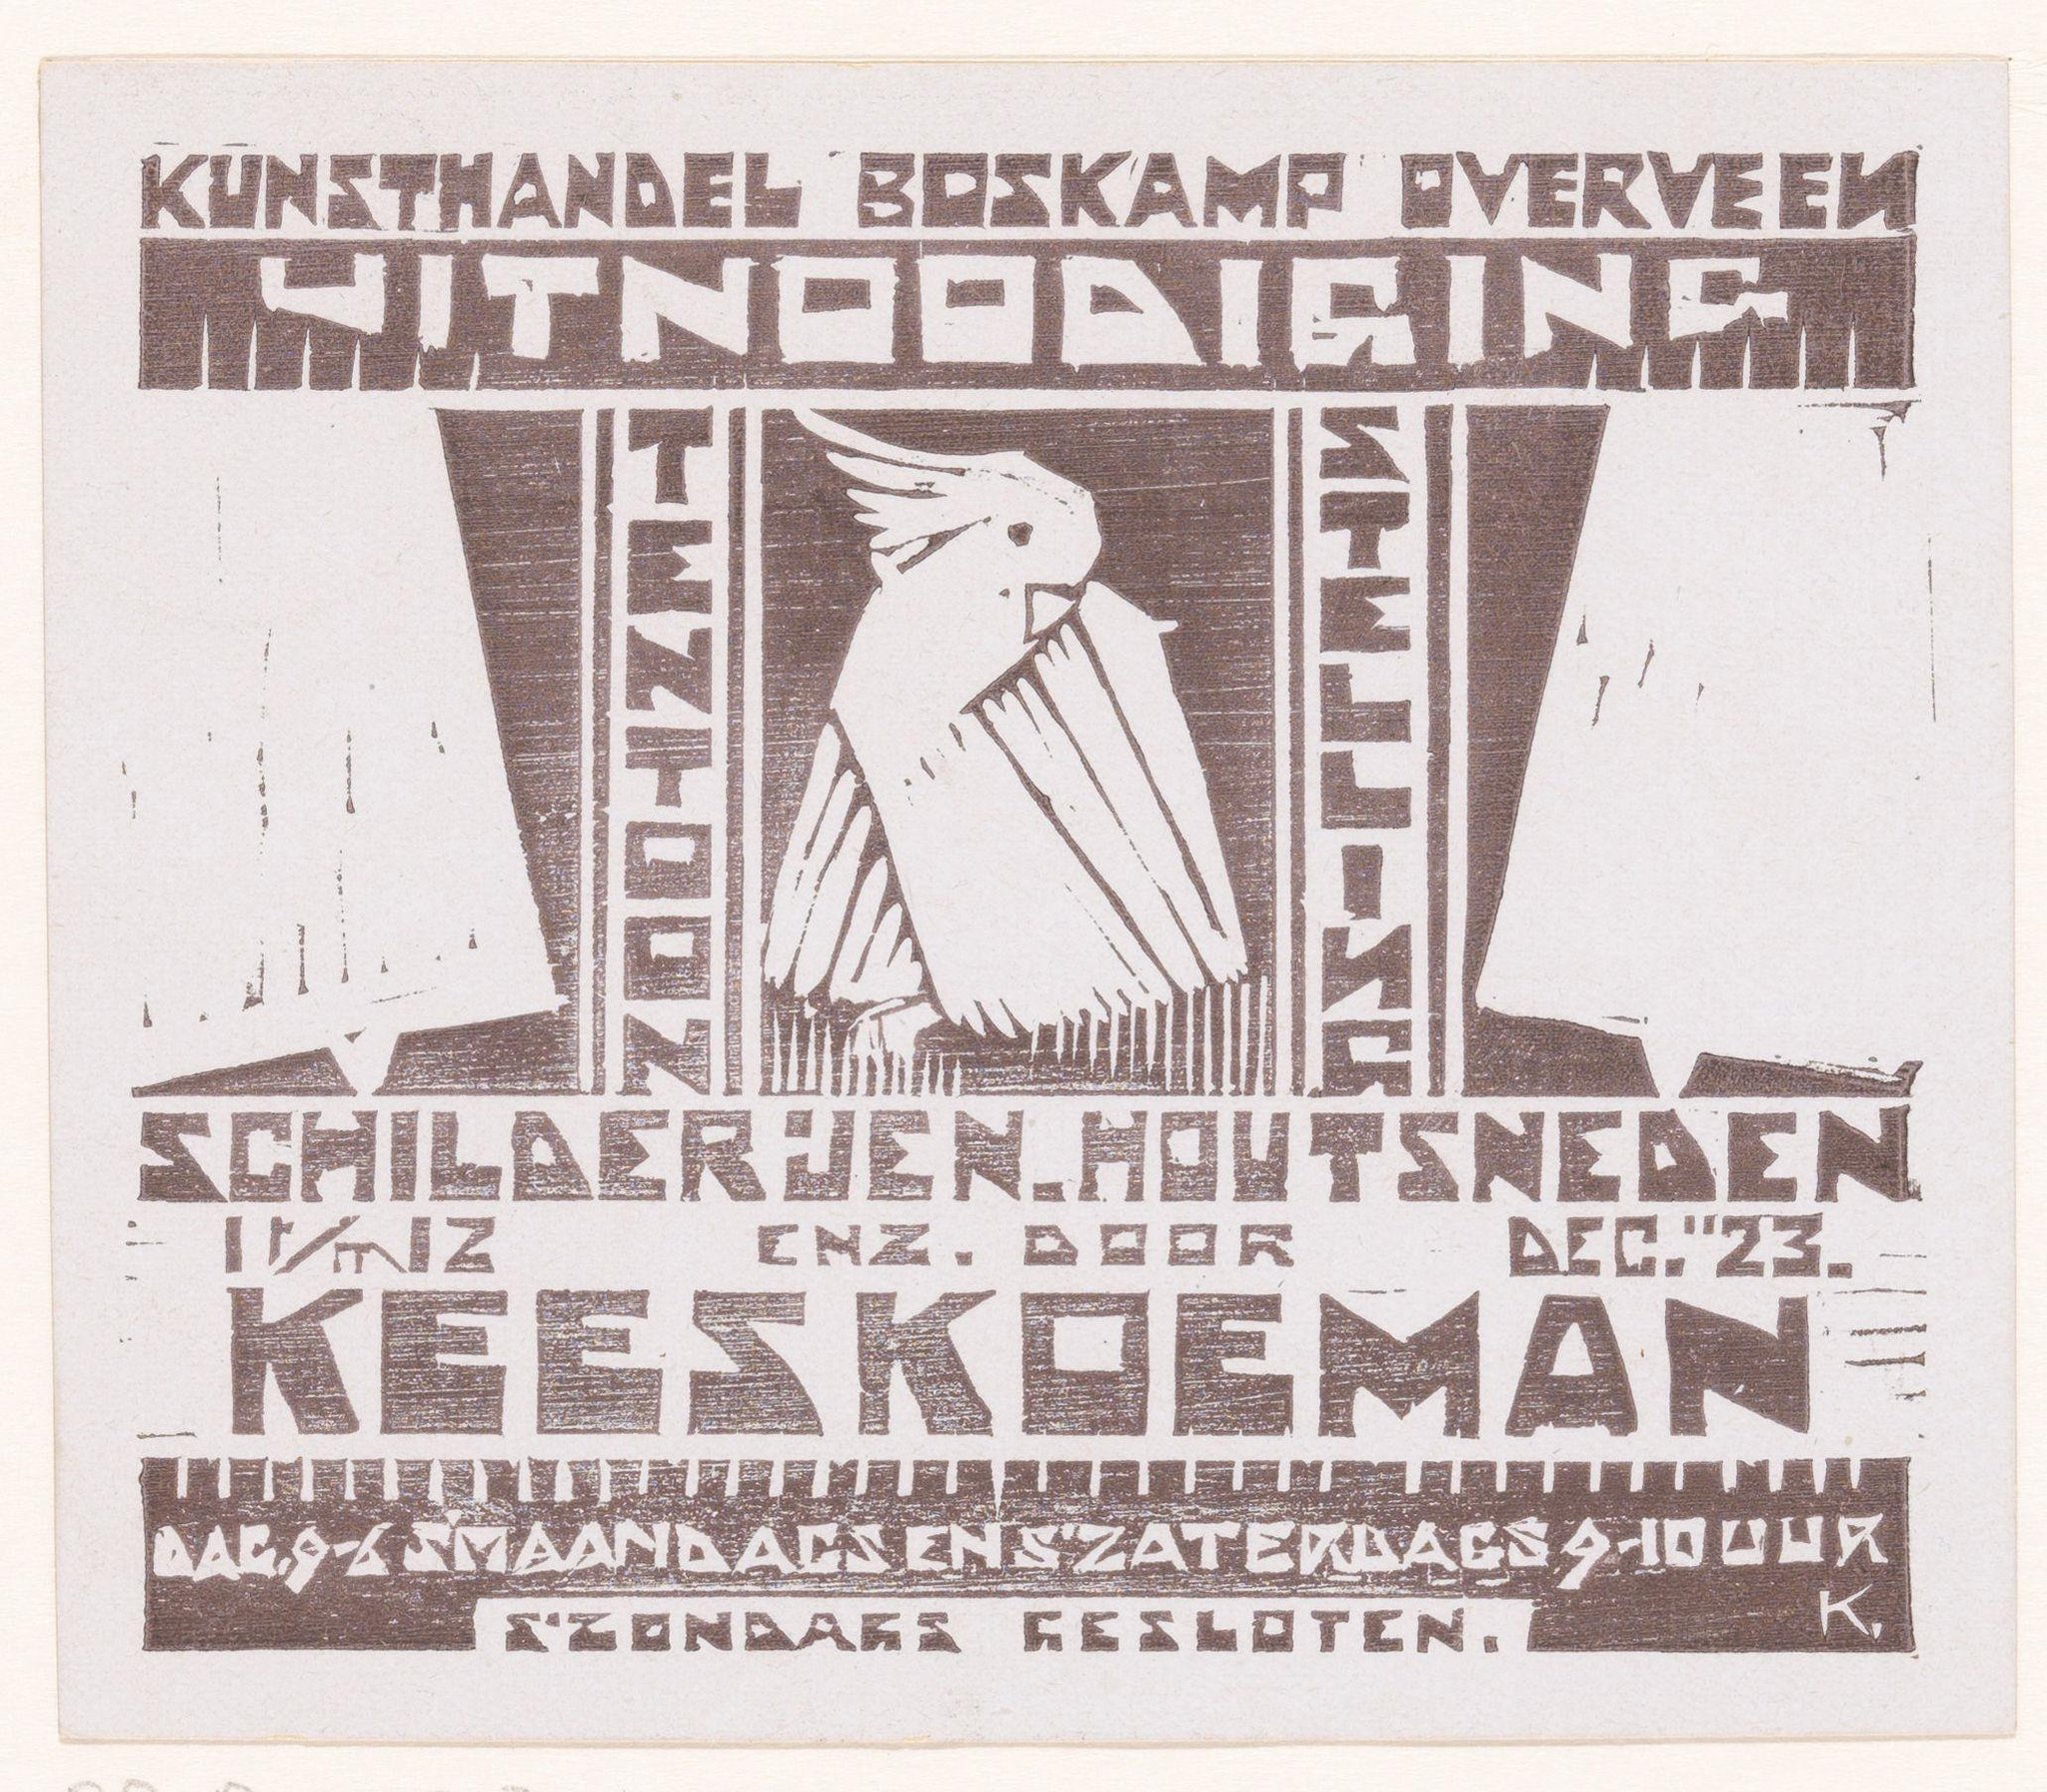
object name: invitation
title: Uitnodiging voor een tentoonstelling van Kees Koeman bij kunsthandel Boskamp Overveen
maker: kees koeman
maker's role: print maker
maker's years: 1895-1954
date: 1912-1923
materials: paper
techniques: woodcut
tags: ornamental birds: cockatoo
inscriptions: collector's mark: Lugt 2228, collector's mark: Lugt 4404